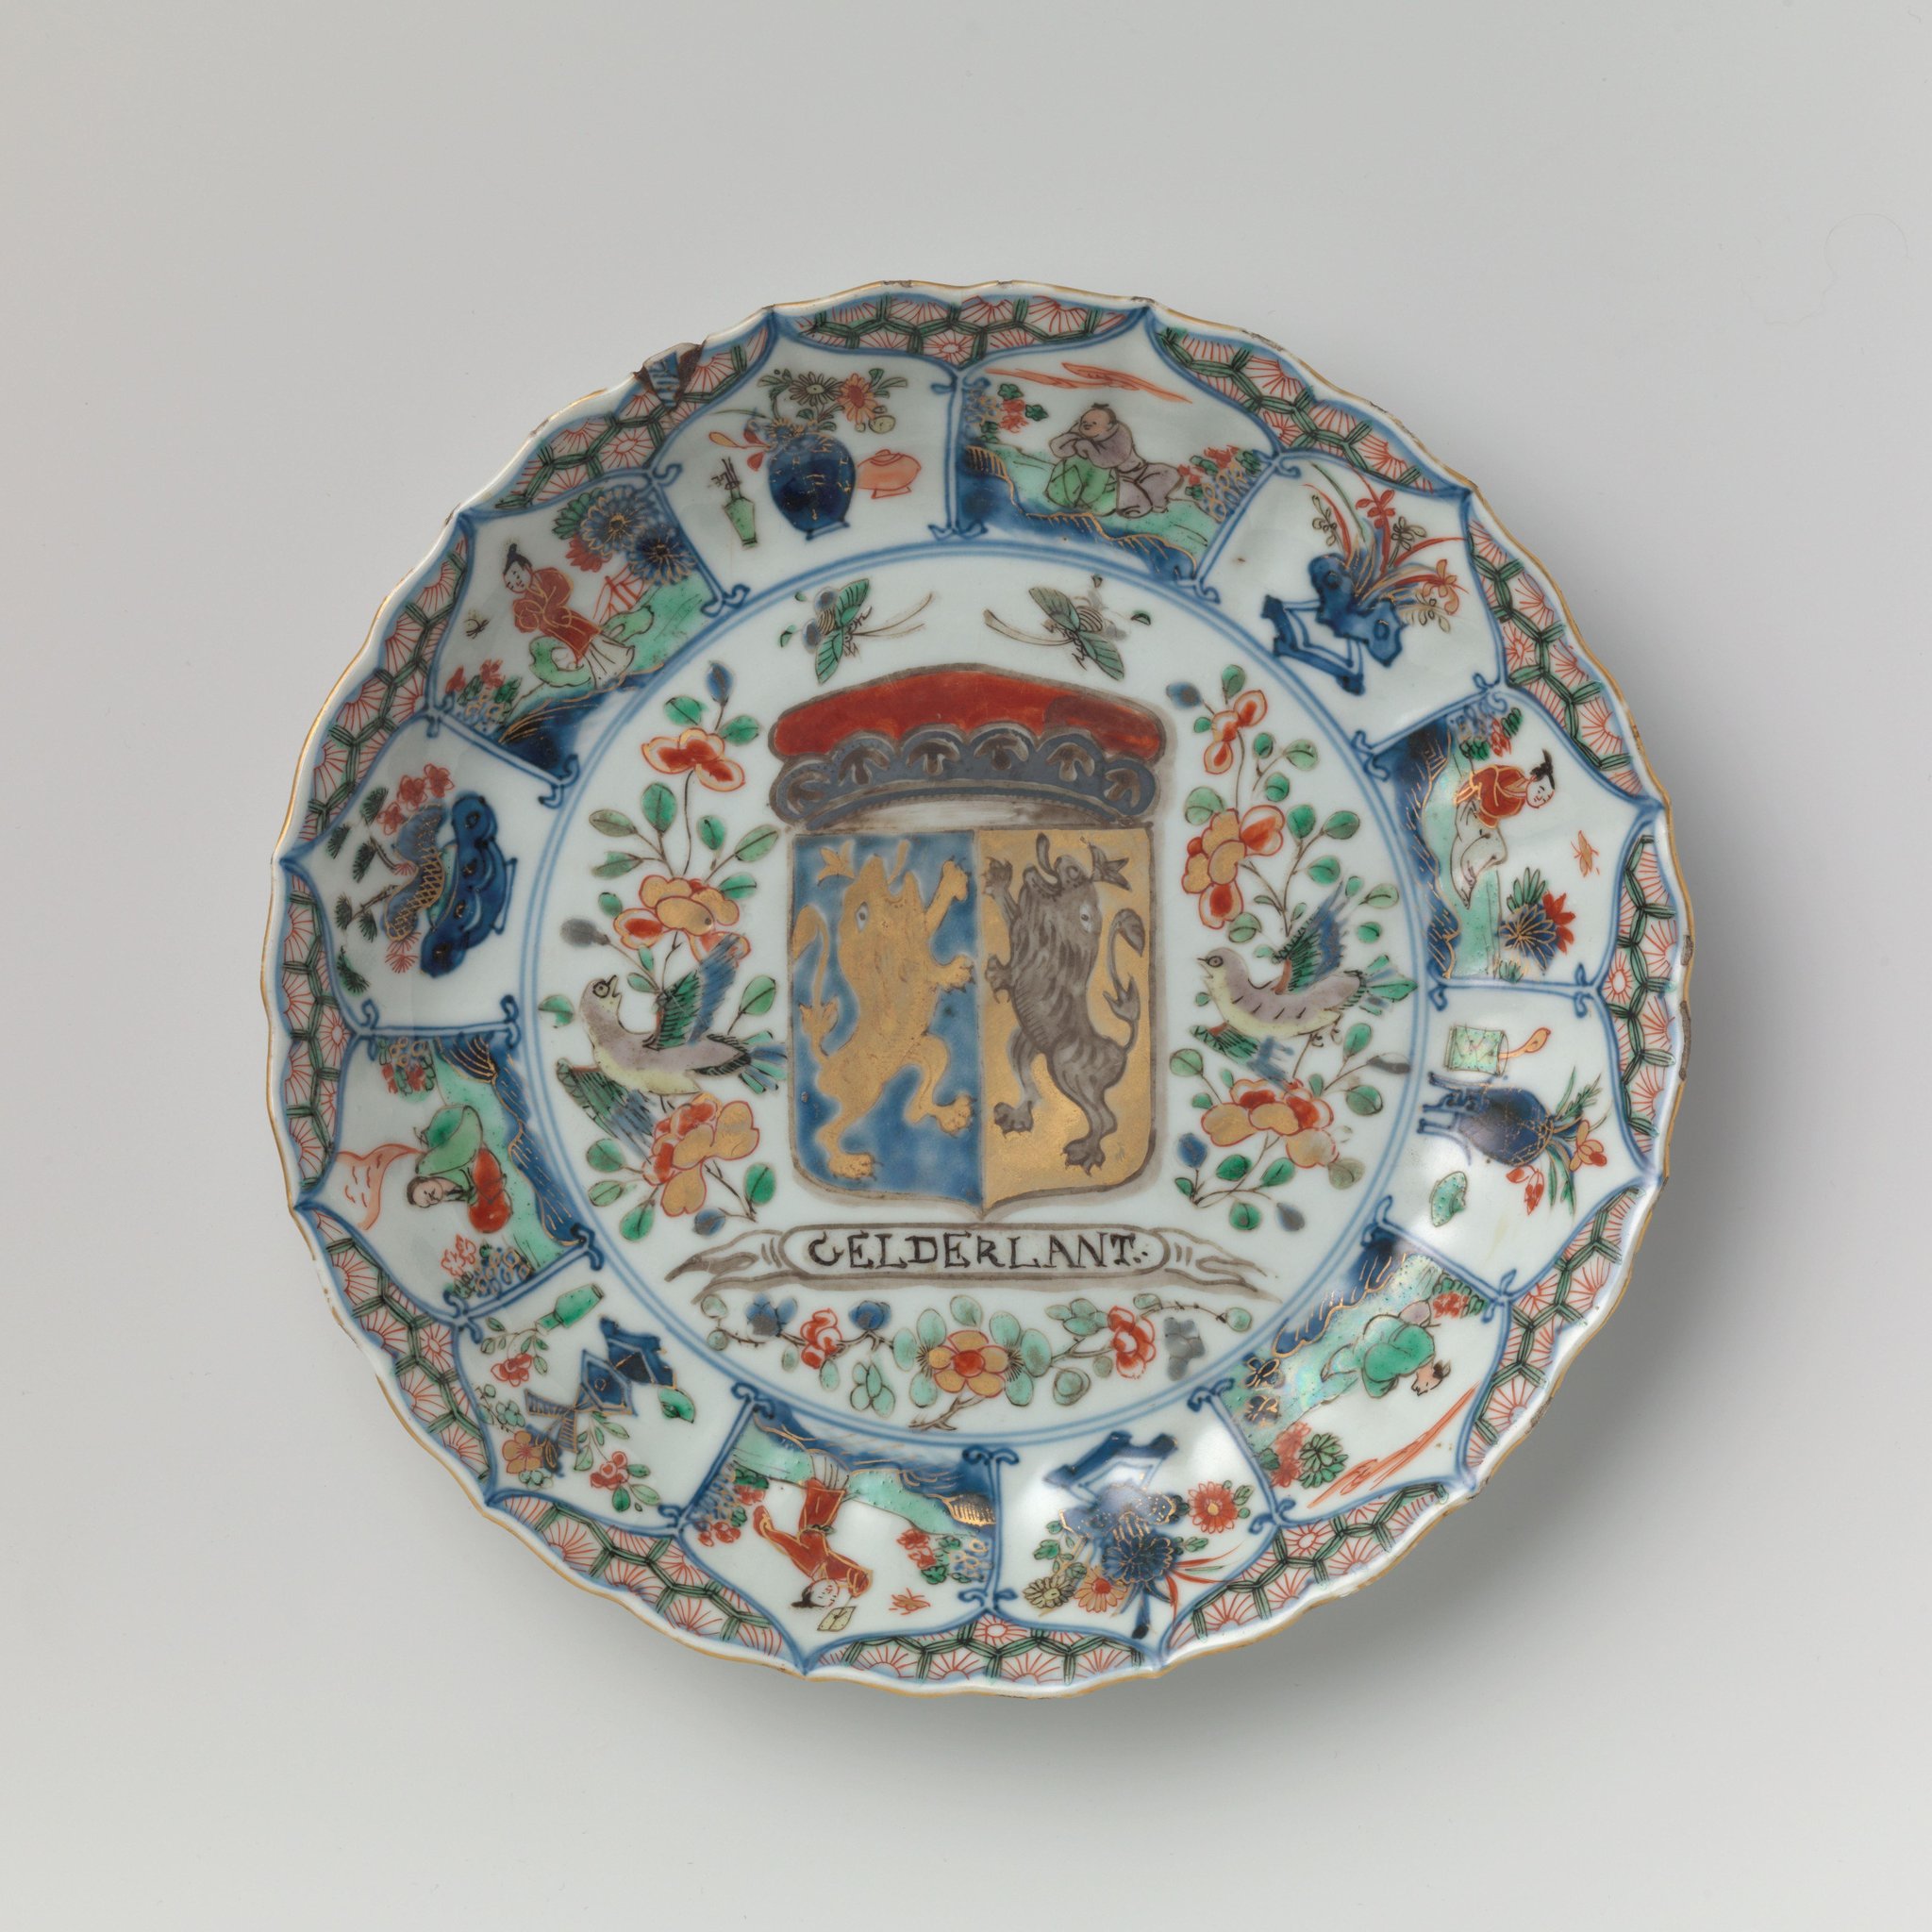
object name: dish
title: Saucer-dish with the arms of Gelderland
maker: Anonymous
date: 1700-1724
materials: cobalt, glaze, gold, paint, porcelain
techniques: firing, gilding, turning, vitrification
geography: china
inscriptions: inscription: ‘Gelderlant’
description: Schaal van porselein met geribde wand en geschulpte rand, beschilderd in onderglazuur blauw en op het glazuur blauw, rood, groen, geel, zwart en goud. Op het plat in een medaillon het wapen van Gelderland met daaronder het opschrift 'Gelderlant', om het wapen bloemtakken, twee vlinders en twee vogels. De wand is verdeeld in twaalf bloembladvormige vakken met afwisselend een bloemenvaas en een persoon in een landschap; tussen de vakken servetwerk. De achterzijde met twee bloemtakken. Enkele barsten en chips in de rand. Wapenporselein met famille verte emailkleuren.